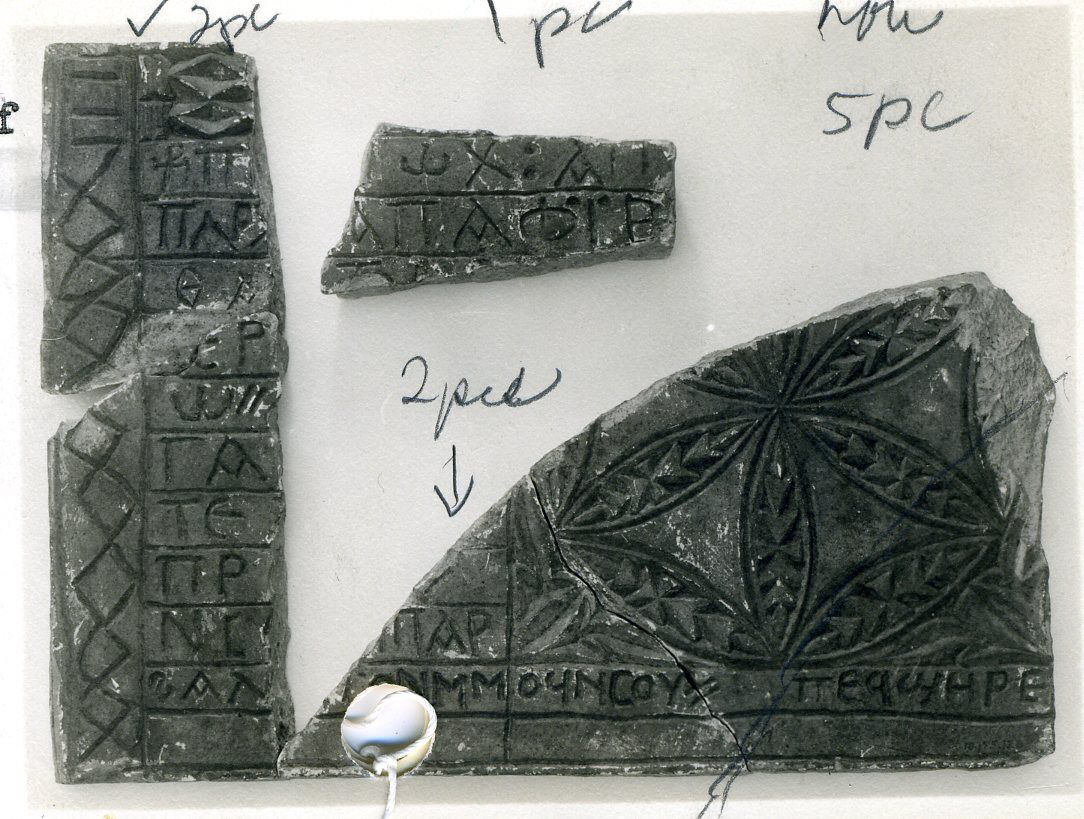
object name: fragment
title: Fragments of an Inscribed Slab with a Rosette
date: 501-700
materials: limestone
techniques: incising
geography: egypt